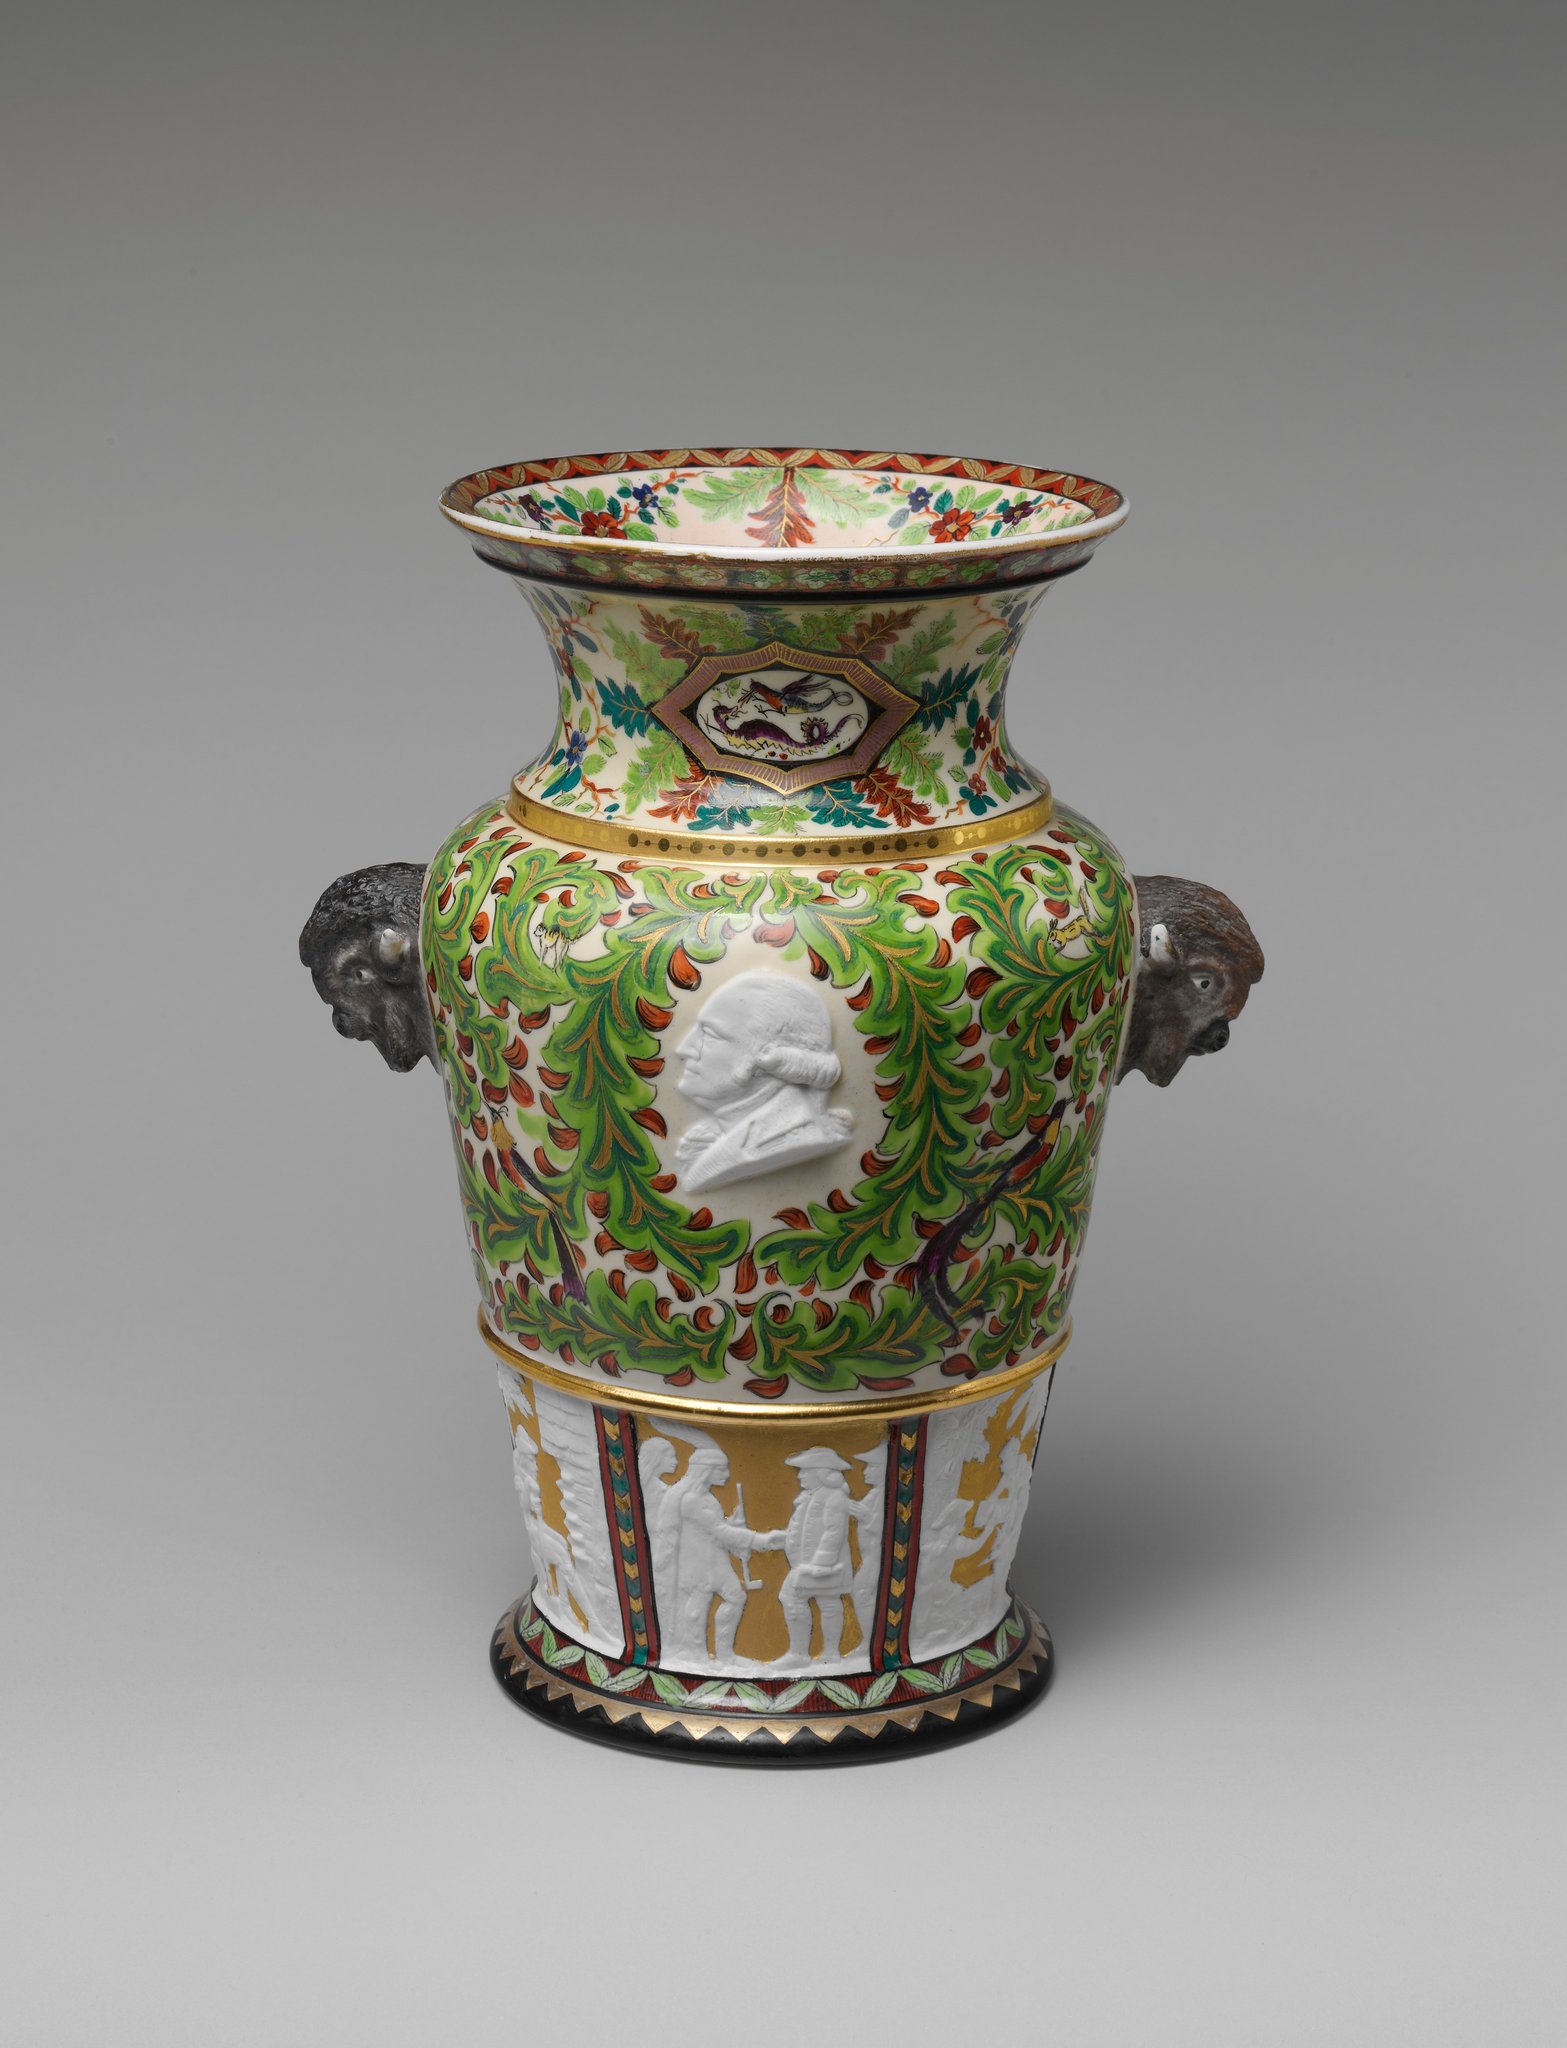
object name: vase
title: Century Vase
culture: american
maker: karl l. h. müller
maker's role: maker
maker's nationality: american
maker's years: 1820-1887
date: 1877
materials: porcelain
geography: united states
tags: animals,george washington